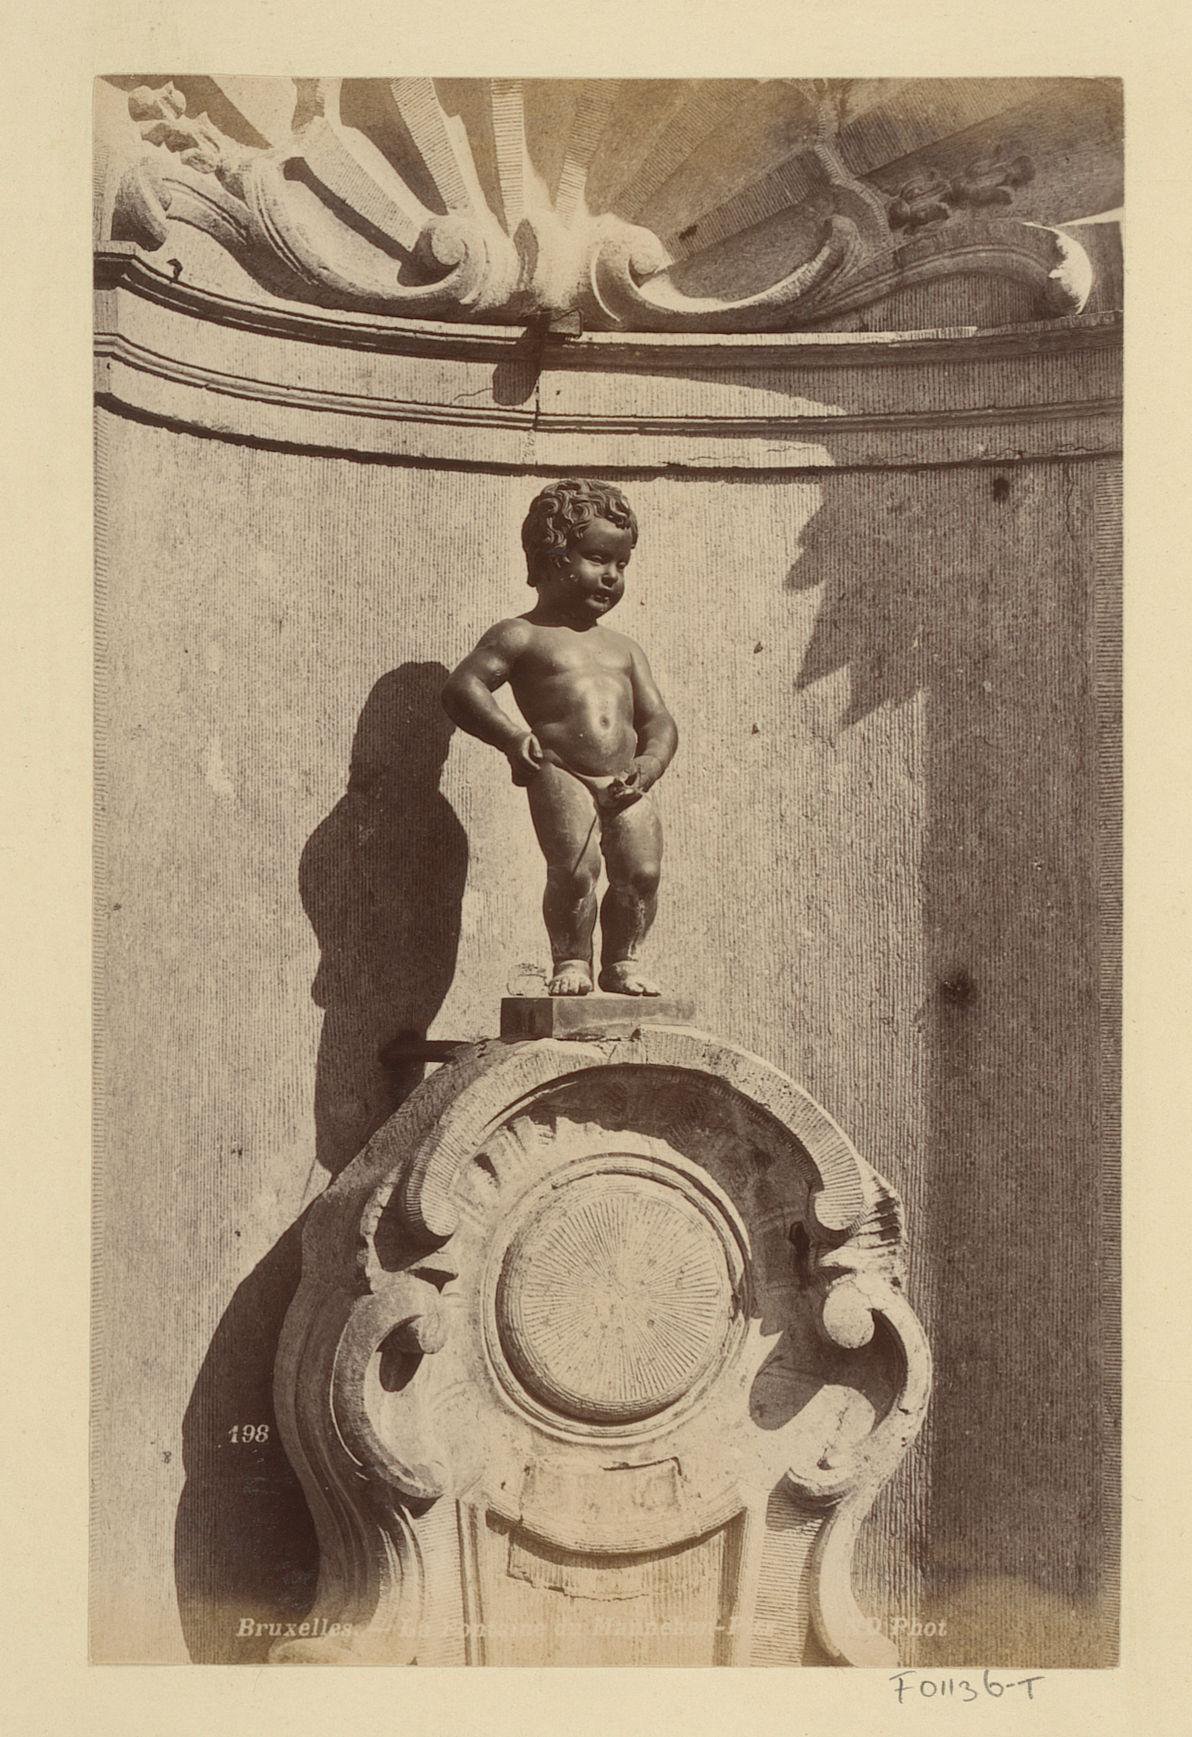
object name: photograph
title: Bruxelles.- La Fontaine du Manneken-Pies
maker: étienne neurdein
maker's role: publisher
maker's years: 1832-1918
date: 1870-1892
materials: photographic support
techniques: albumen print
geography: brussels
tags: monument, statue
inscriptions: number: ‘198’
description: Onderdeel van Fotoalbum met opnames van bezienswaardigheden in België, Duitsland en Noorwegen.